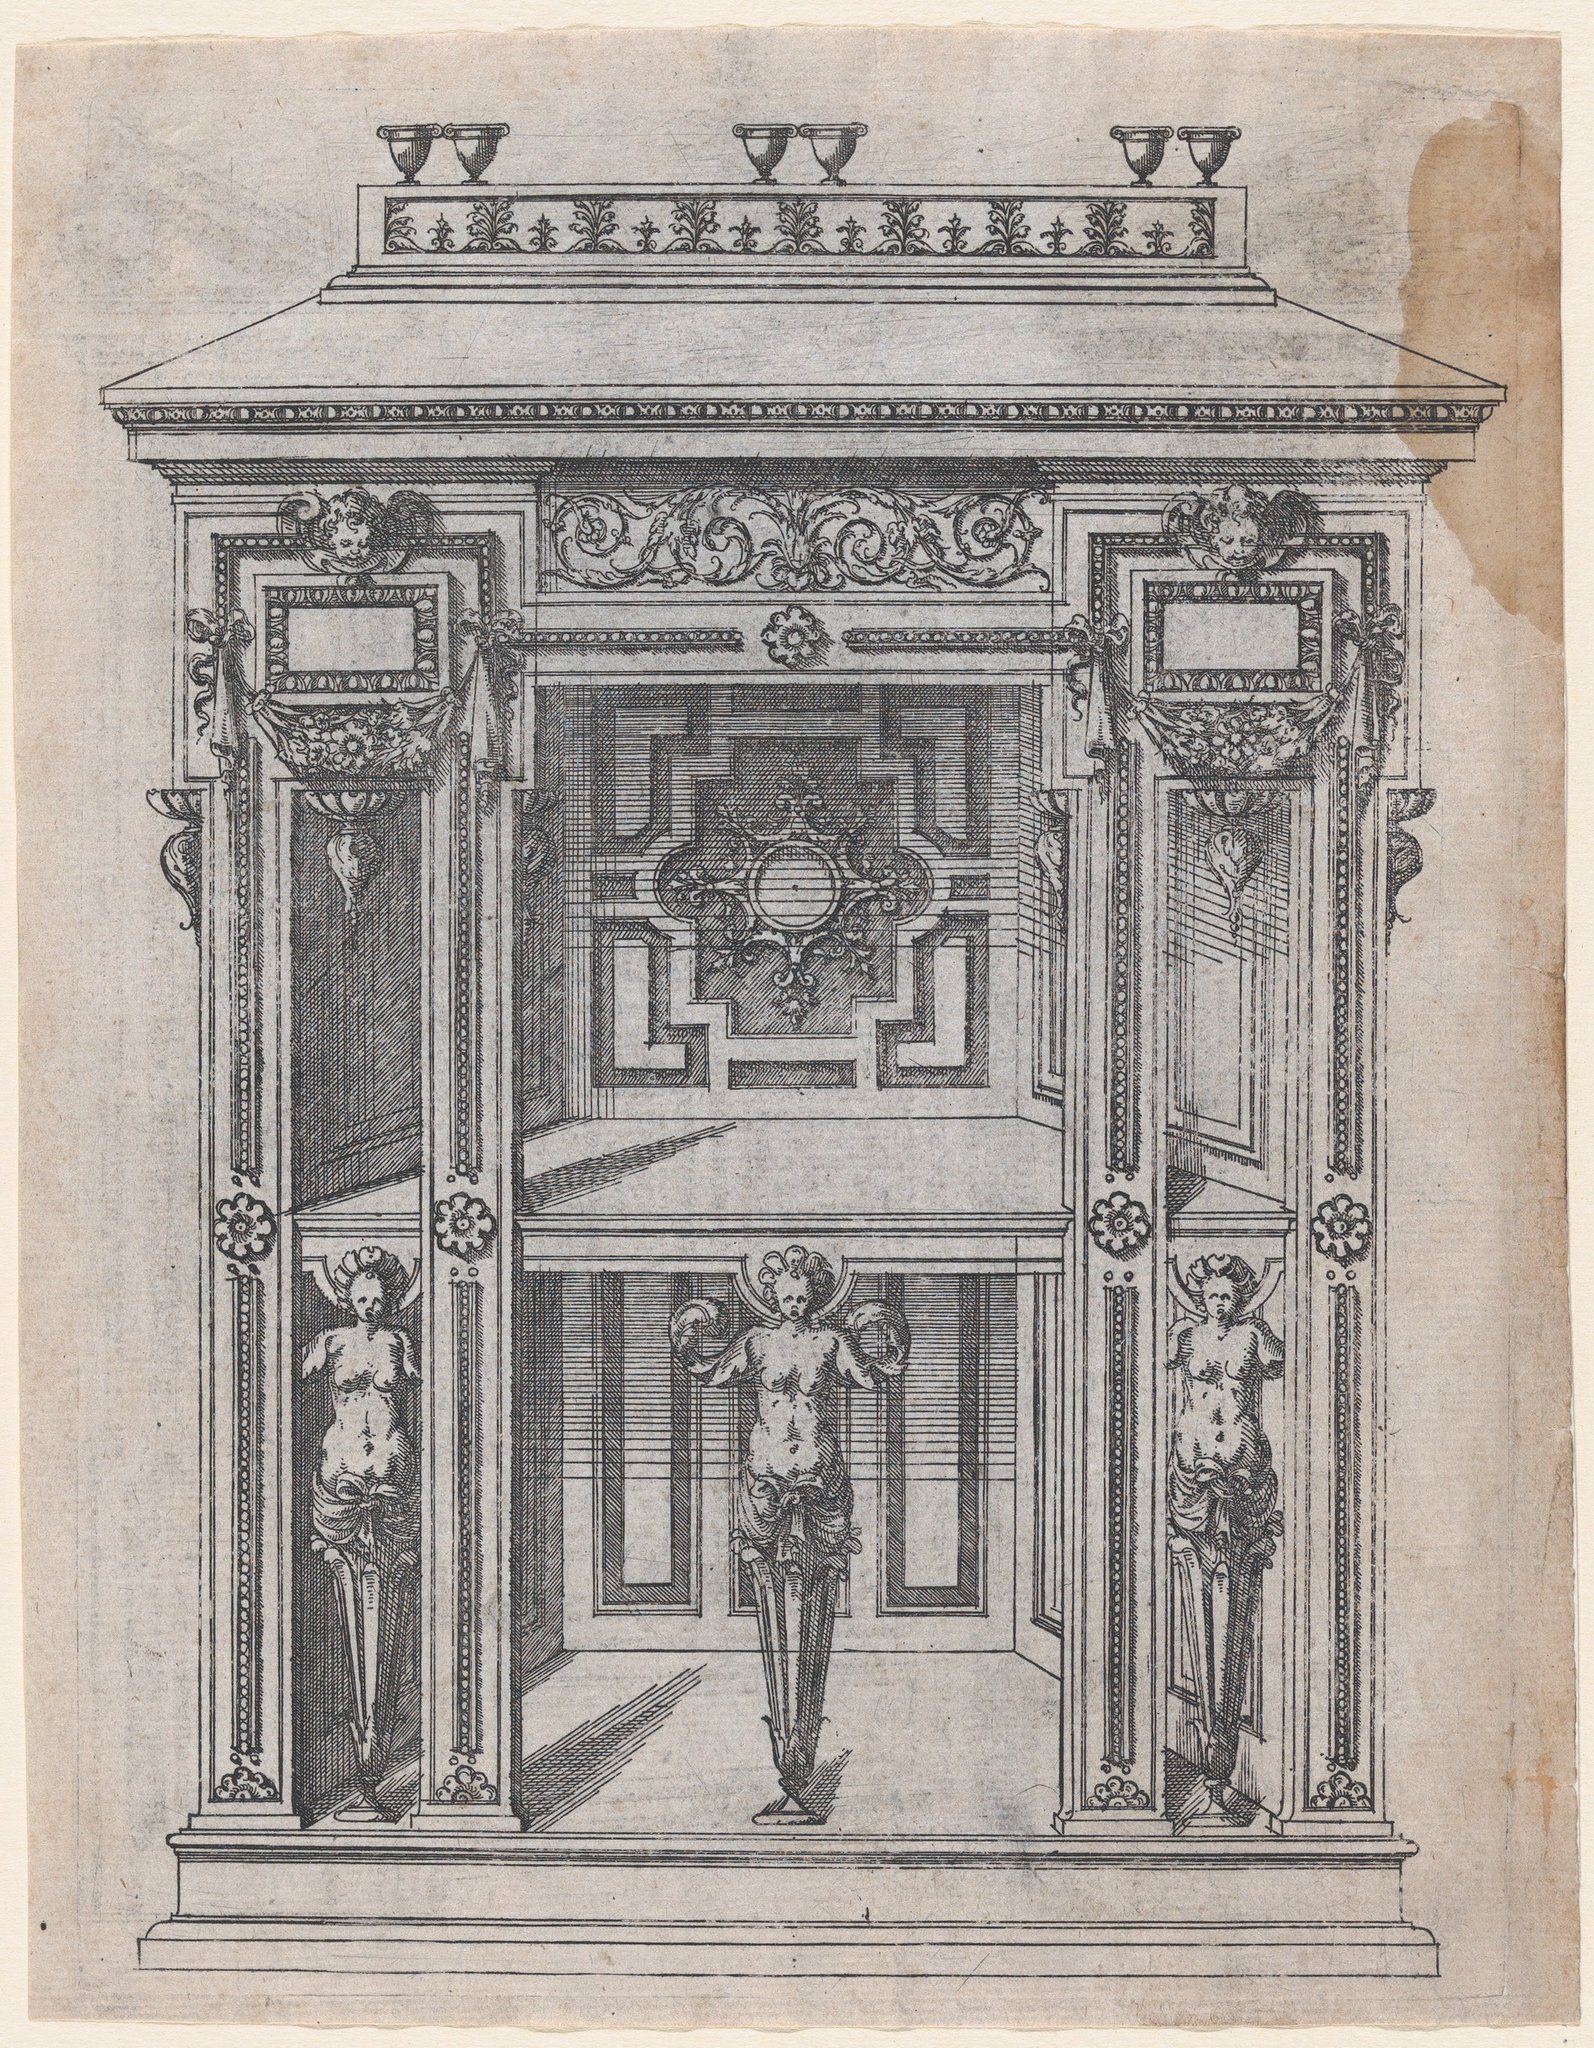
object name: print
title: Furniture Design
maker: jacques androuet du cerceau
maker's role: artist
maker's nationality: french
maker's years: 1510-1585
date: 1565-1570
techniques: etching